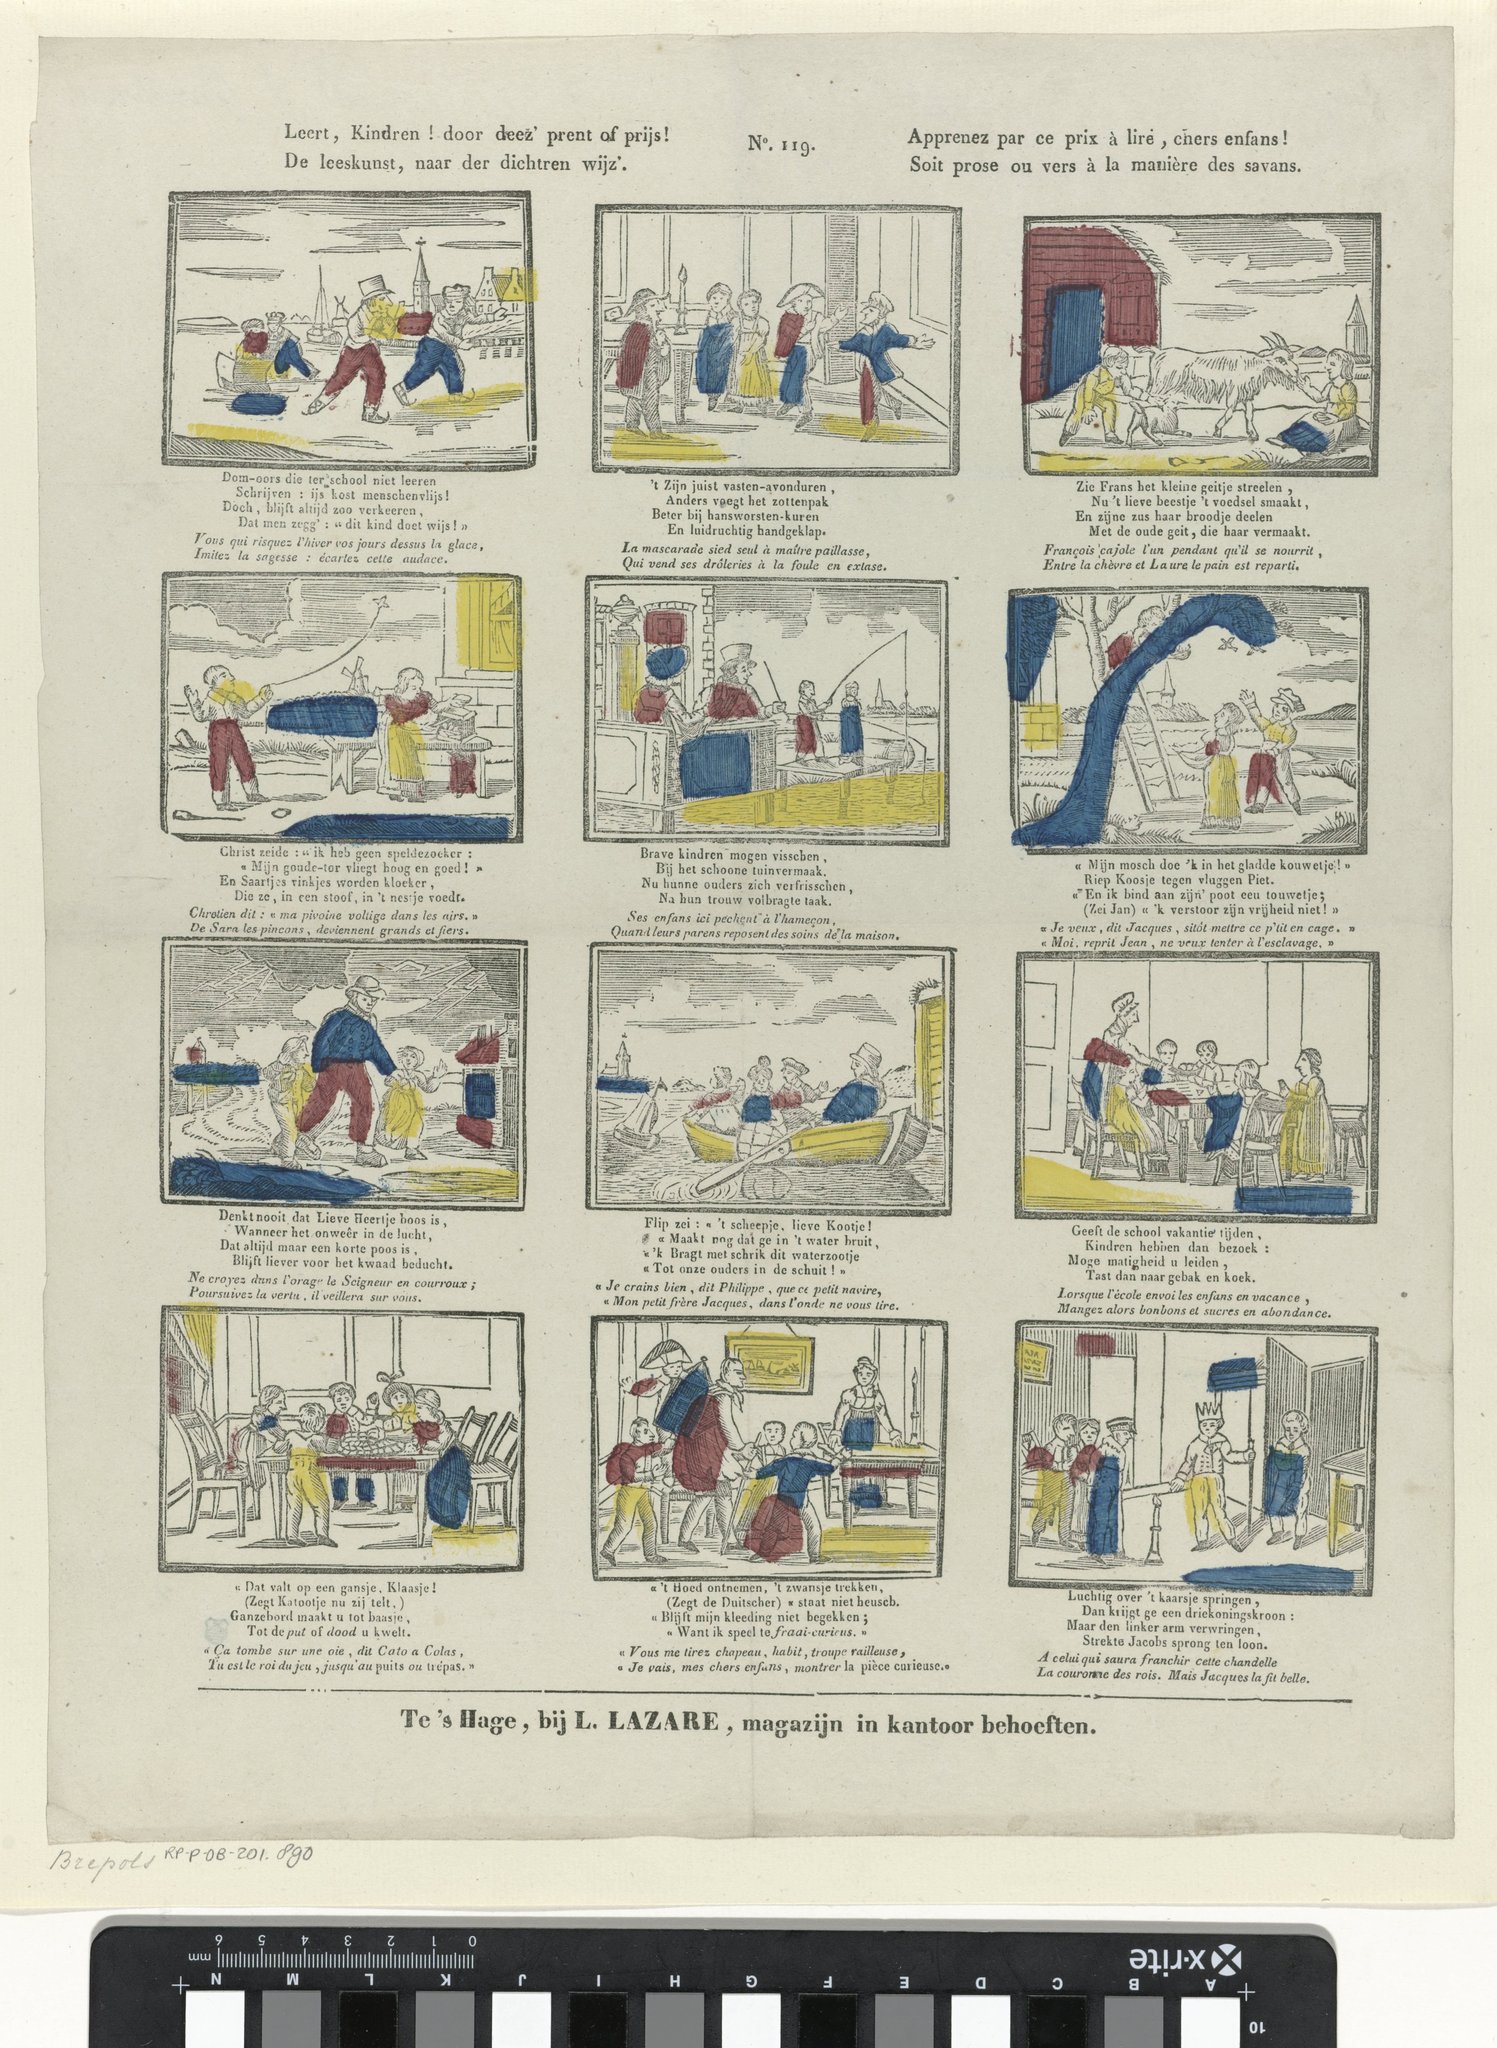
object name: print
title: Leert, kindren! door deez' prent of prijs! / De leeskunst, naar der dichtren wijz'. / Apprenez par ce prix à lire, chers enfants! / Soit prose ou en vers, à la manière des savans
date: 1800-1833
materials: paper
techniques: colour, letterpress printing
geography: turnhout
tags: children's games and plays, skates (winter sports), (flying a) kite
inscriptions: collector's mark: Lugt 2760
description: Blad met 12 voorstellingen van verschillende kinderspelen en bezigheden, waaronder schaatsen, vliegeren en koek eten. Onder elke voorstelling een vierregelig vers in het Nederlands en een tweeregelig vers in het Frans. Genummerd midden boven: No. 119.